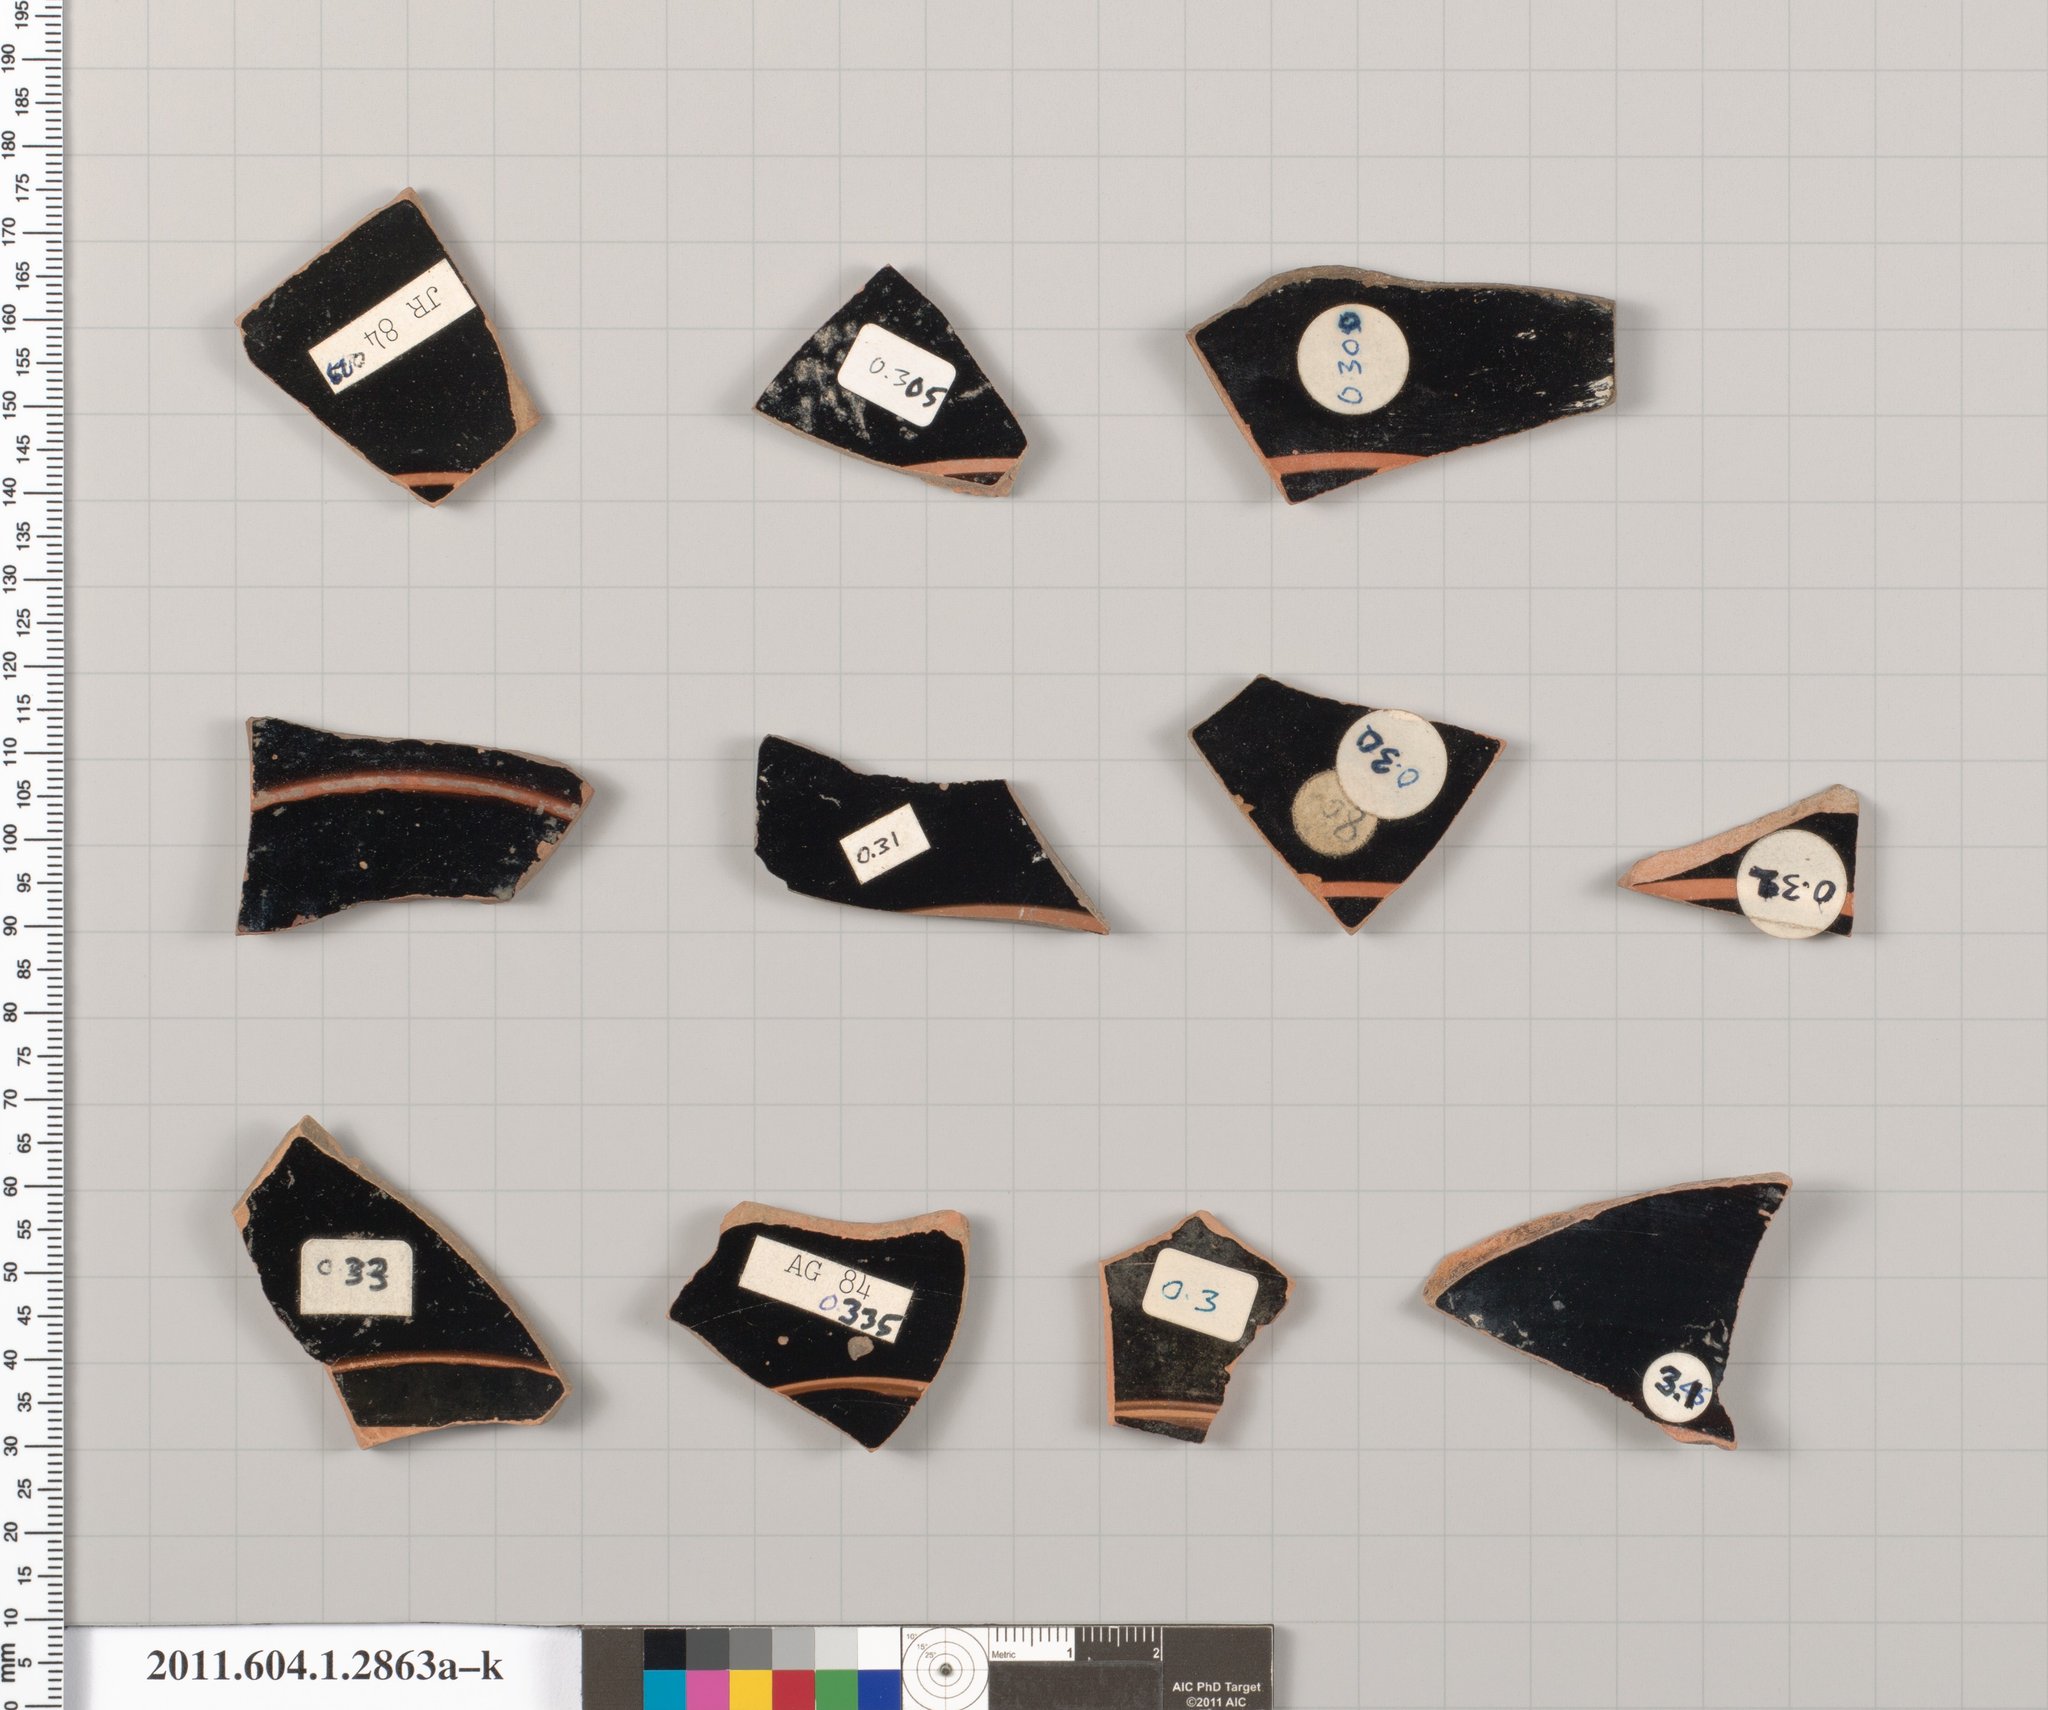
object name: kylix fragment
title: Terracotta fragments of kylikes (drinking cups)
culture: greek, attic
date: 600-401 BCE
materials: terracotta